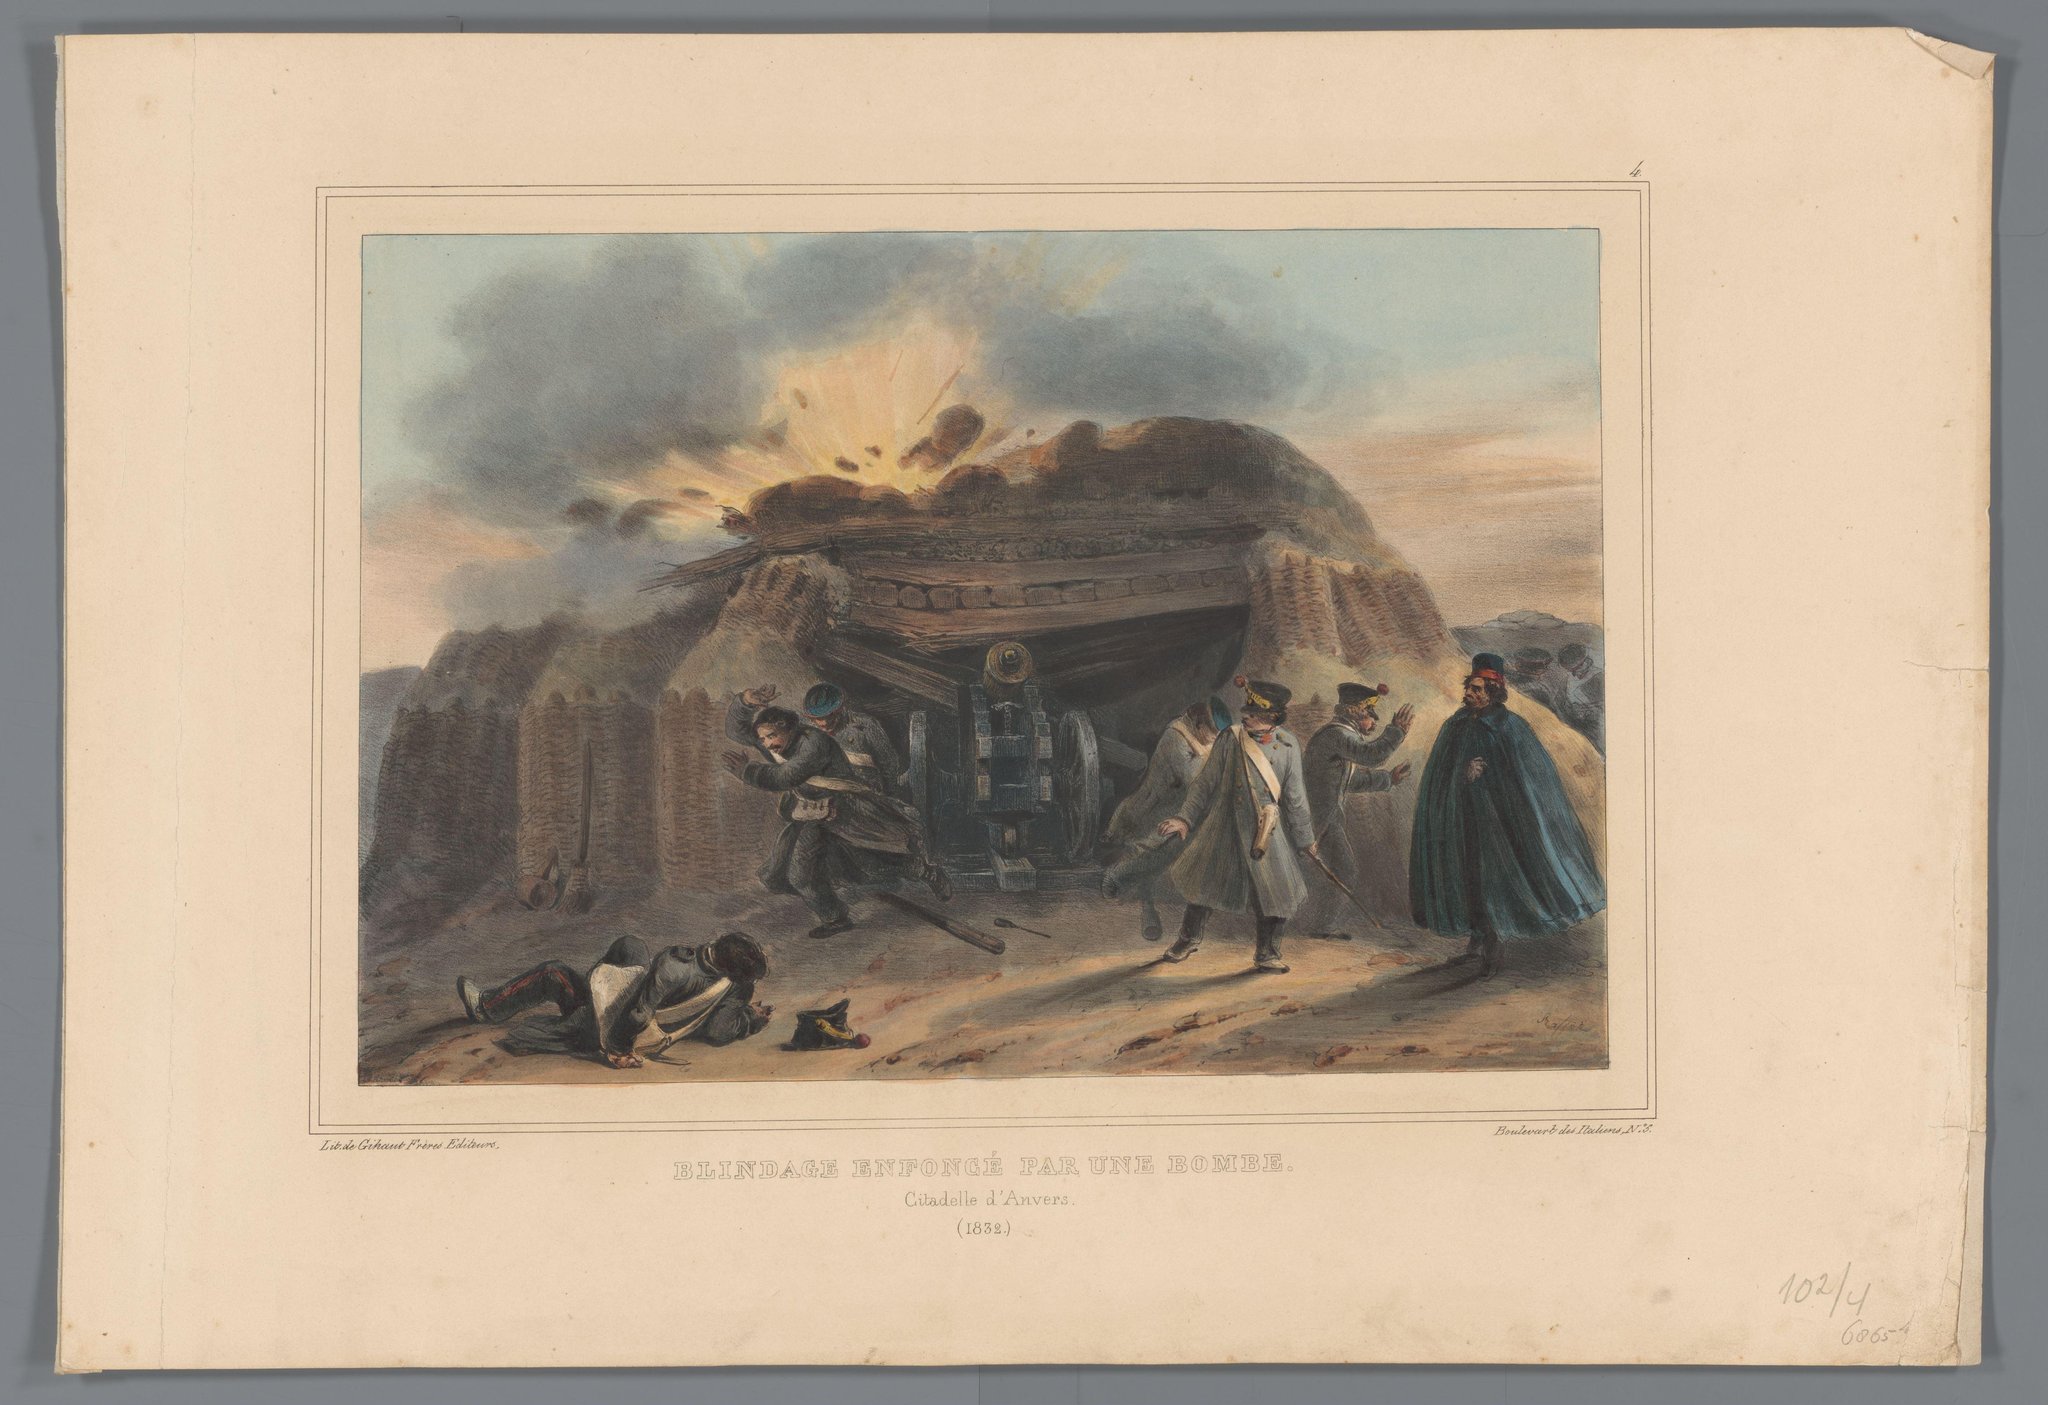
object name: print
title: Bominslag op een ingegraven kanon, 1832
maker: denis auguste marie raffet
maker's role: draughtsman, print maker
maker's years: 1804-1860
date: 1833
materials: lacquer, paper, watercolor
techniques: hand coloring, lacquer, lithograph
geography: france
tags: siege, position war, bombardment ~ siege, antwerp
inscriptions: signature: ‘Raffet’, caption: ‘BLINDAGE ENFONCE PAR UNE BOMBE. / Citadelle d'Anvers. / (1832.)’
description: Bominslag op een ingegraven kanon. Enkele militairen vluchten weg. Links voor ligt een gewonde. Onderdeel van de serie van 24 prenten over het beleg van de Citadel van Antwerpen, 30 november - 23 december 1832.